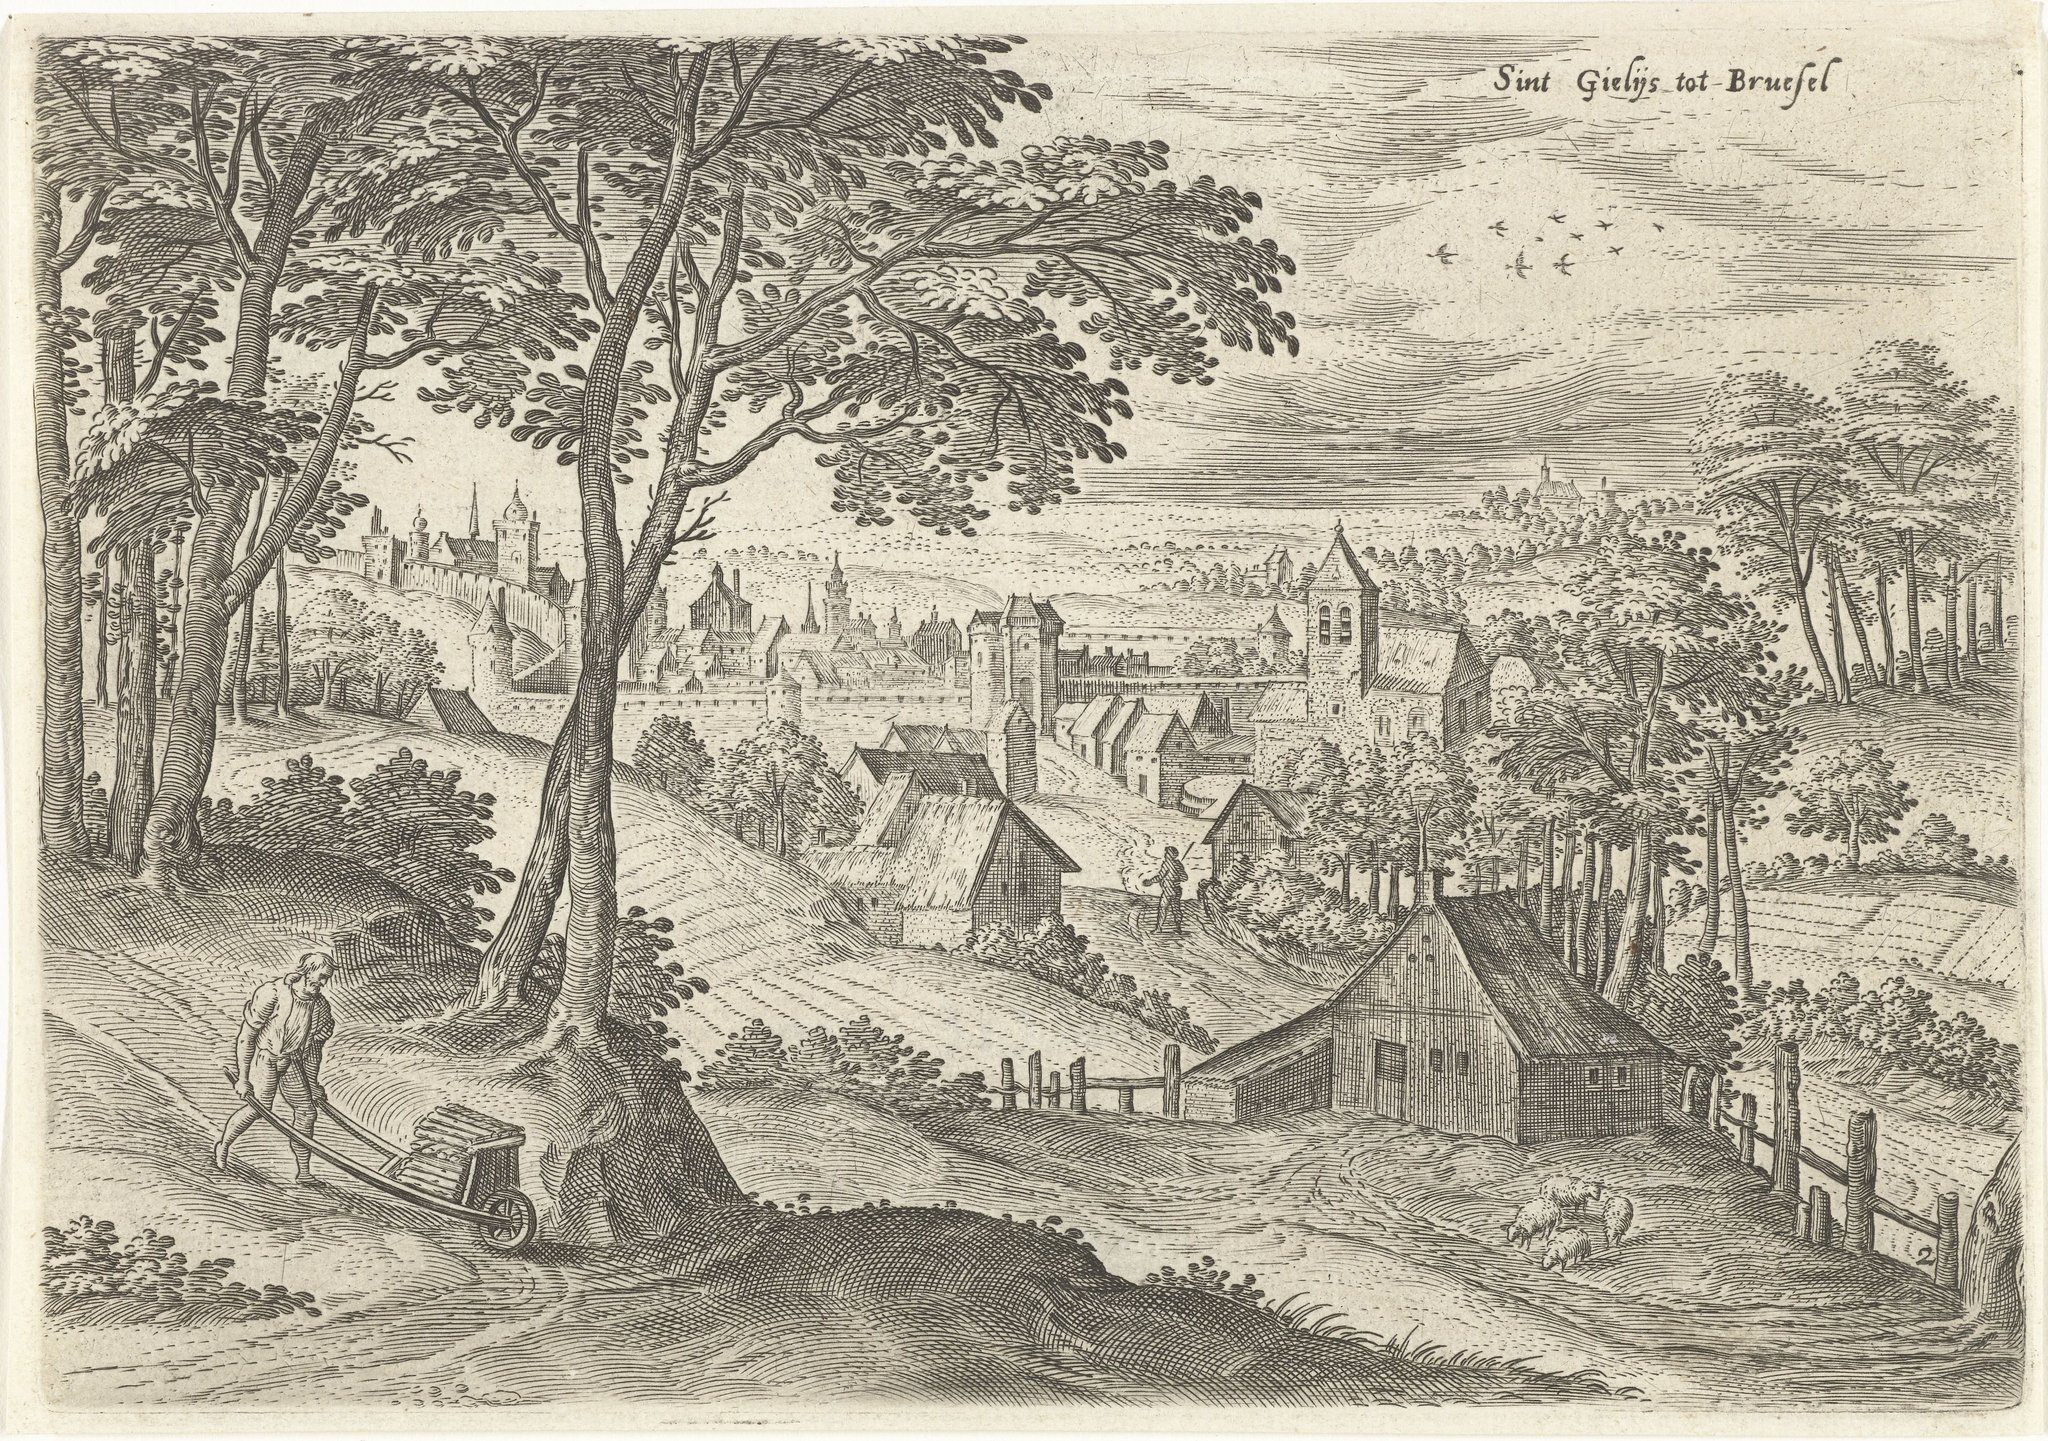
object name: print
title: Sint Gielijs tot Brussel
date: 1530-1580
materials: paper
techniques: engraving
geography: antwerp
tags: meadow, pasture (+ landscape with figures, staffage)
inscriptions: collector's mark: Lugt 2228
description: Gezicht op het dorp Sint-Gillis en het zuidoostelijk deel van de Brusselse omwalling met de Hallepoort. De prent is deel van een serie met gezichten uit de omgeving van Brussel.